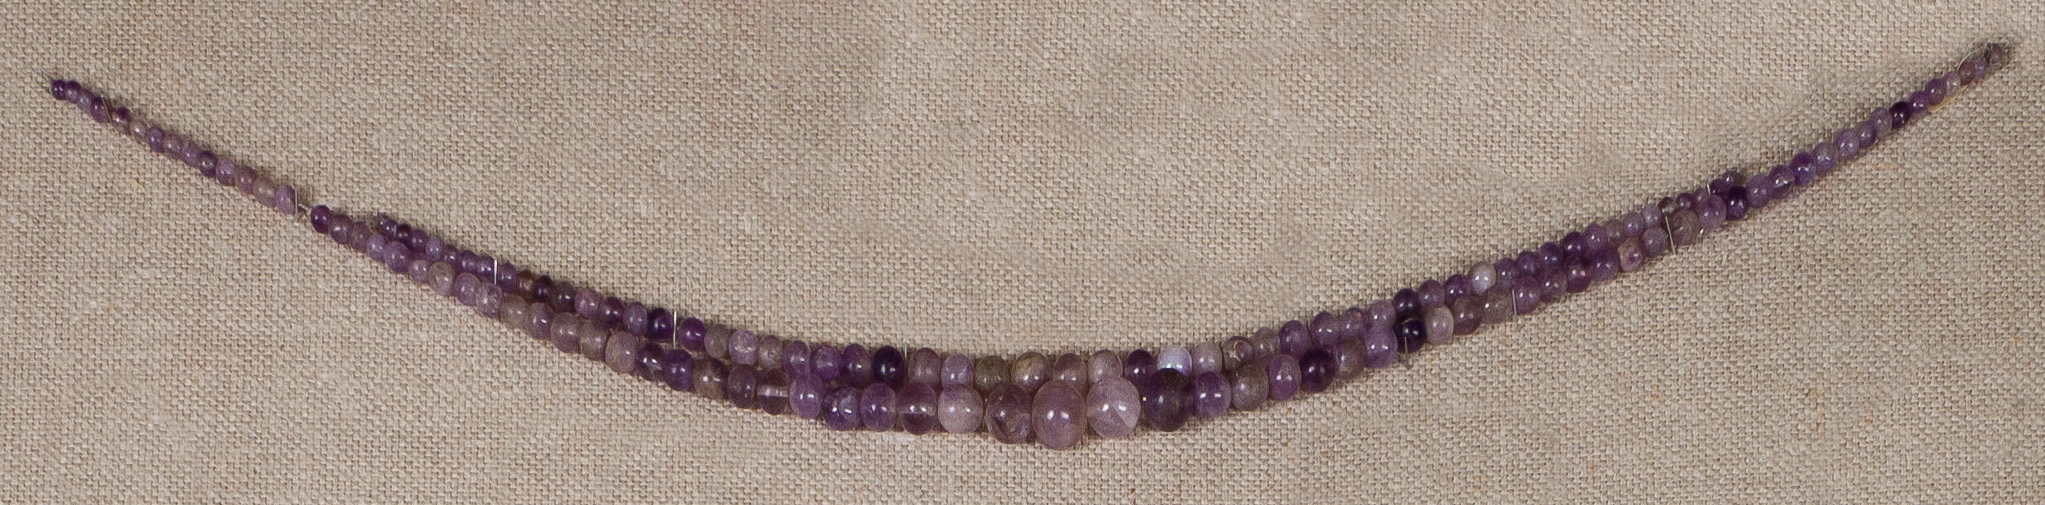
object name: necklace, bead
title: String of Amethyst Ball Beads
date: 1981-1295 BCE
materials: gemstone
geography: egypt